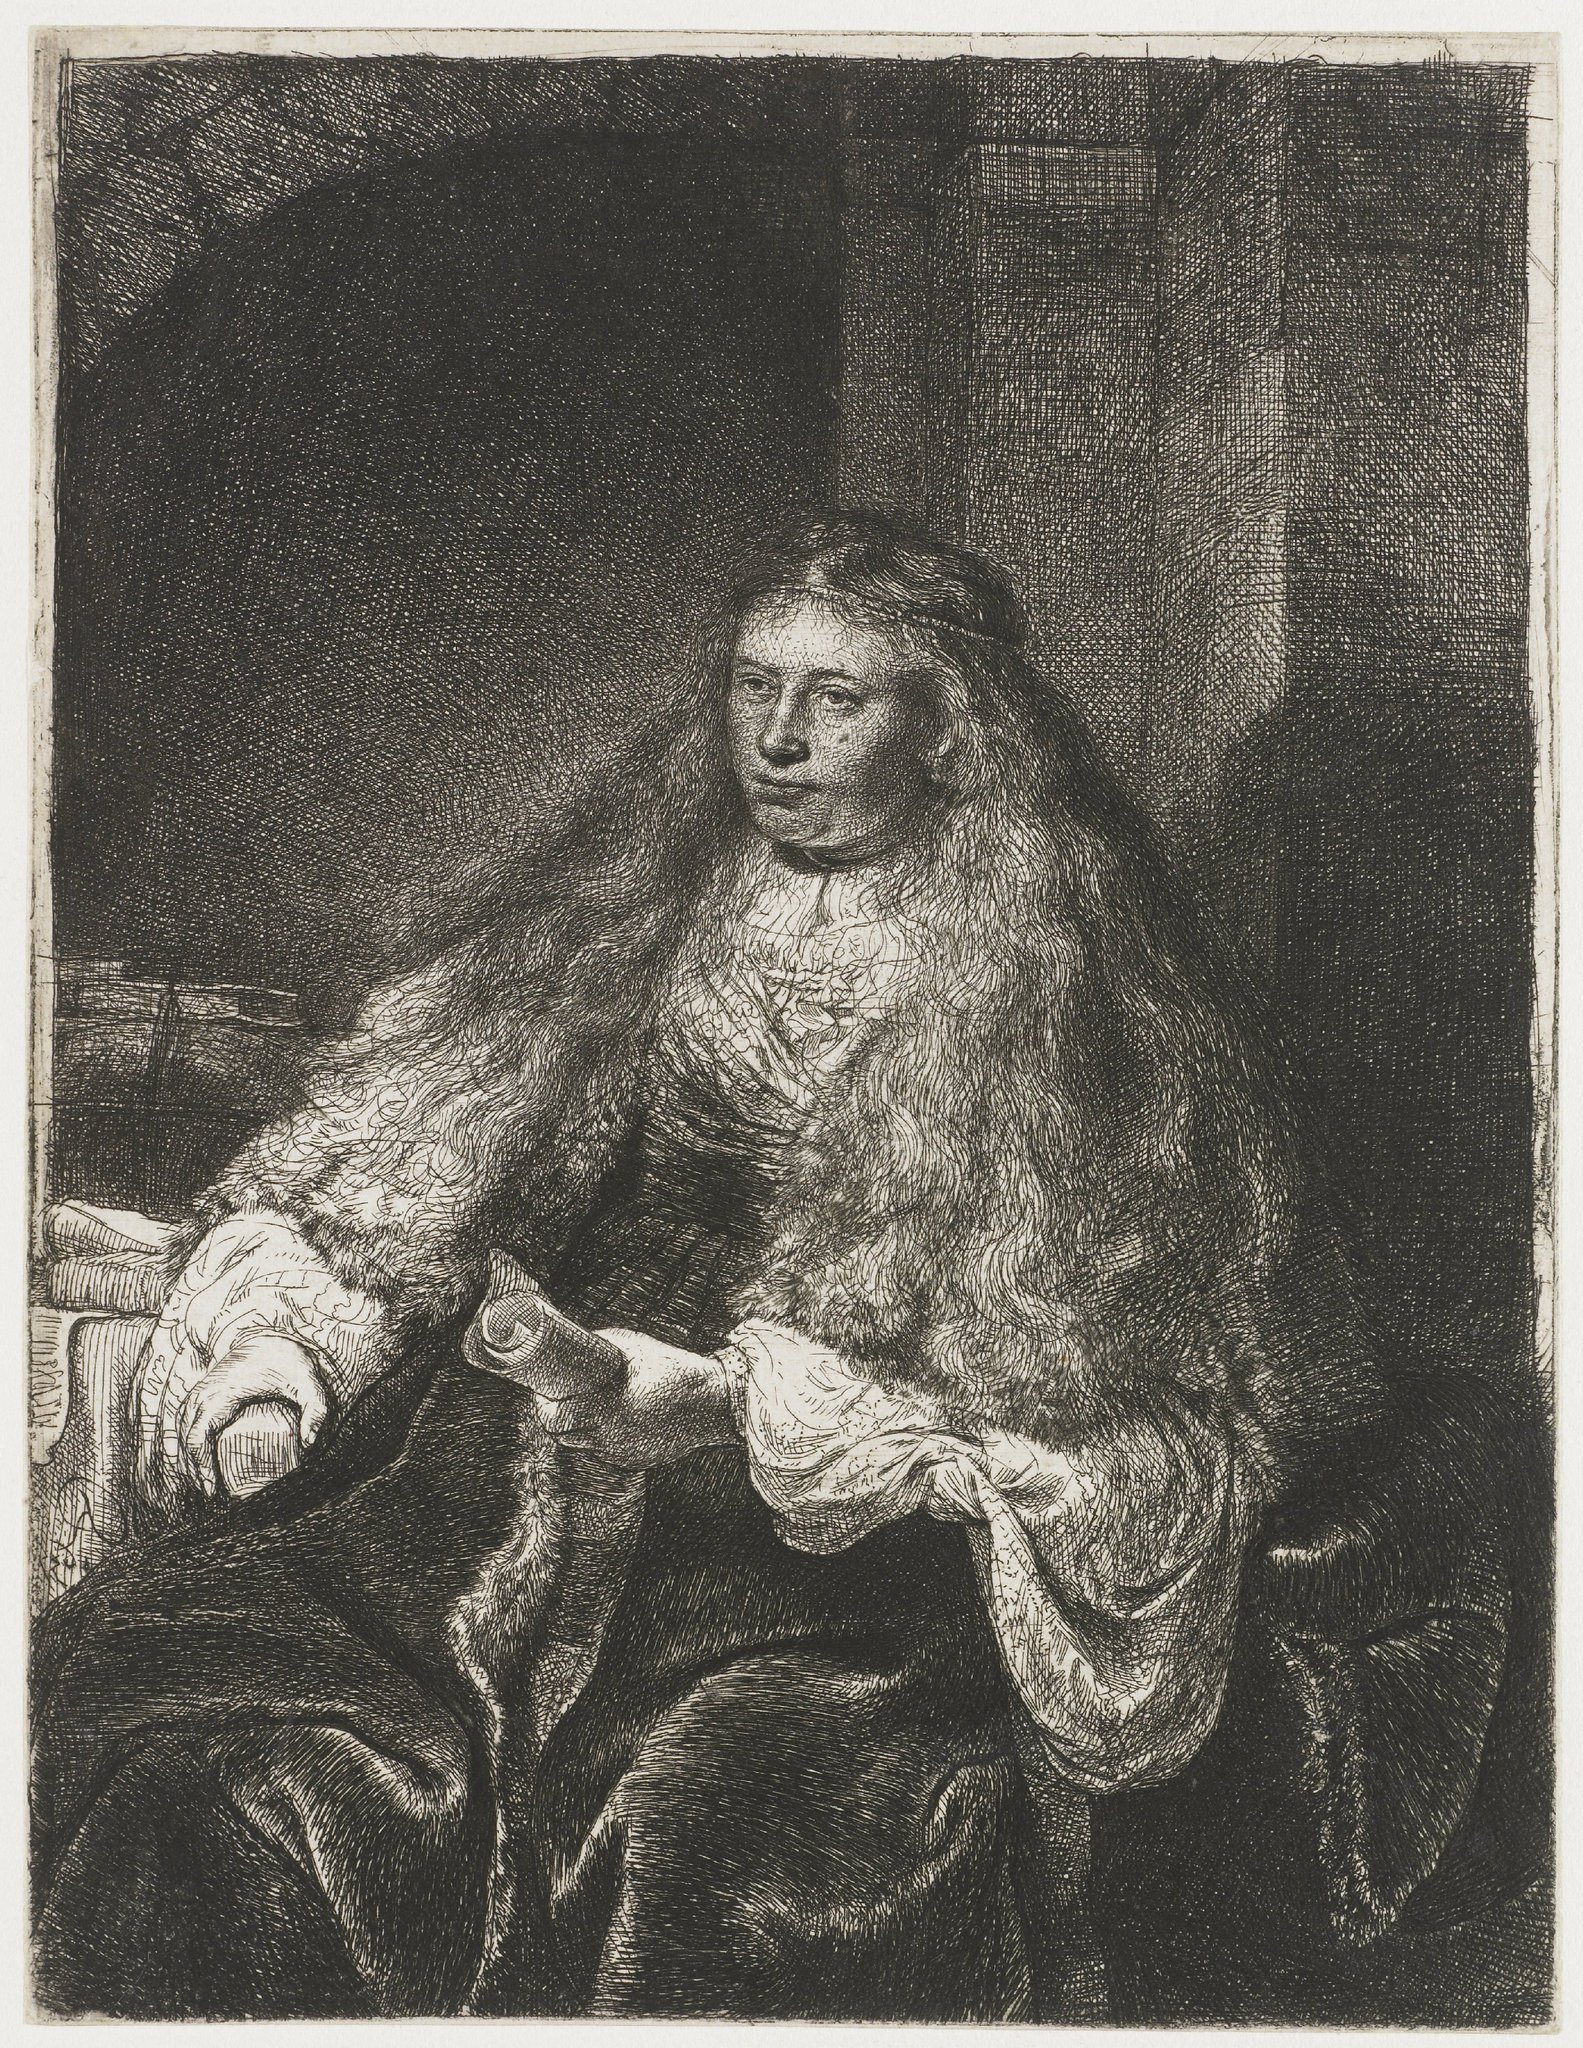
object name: print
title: The great Jewish bride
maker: rembrandt van rijn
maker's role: draughtsman, painter, print maker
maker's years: 1606-1669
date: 1635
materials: paper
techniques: drypoint, etching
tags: bride (in wedding-dress)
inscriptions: monogram and date: ‘R 1635’, collector's mark: Lugt 240